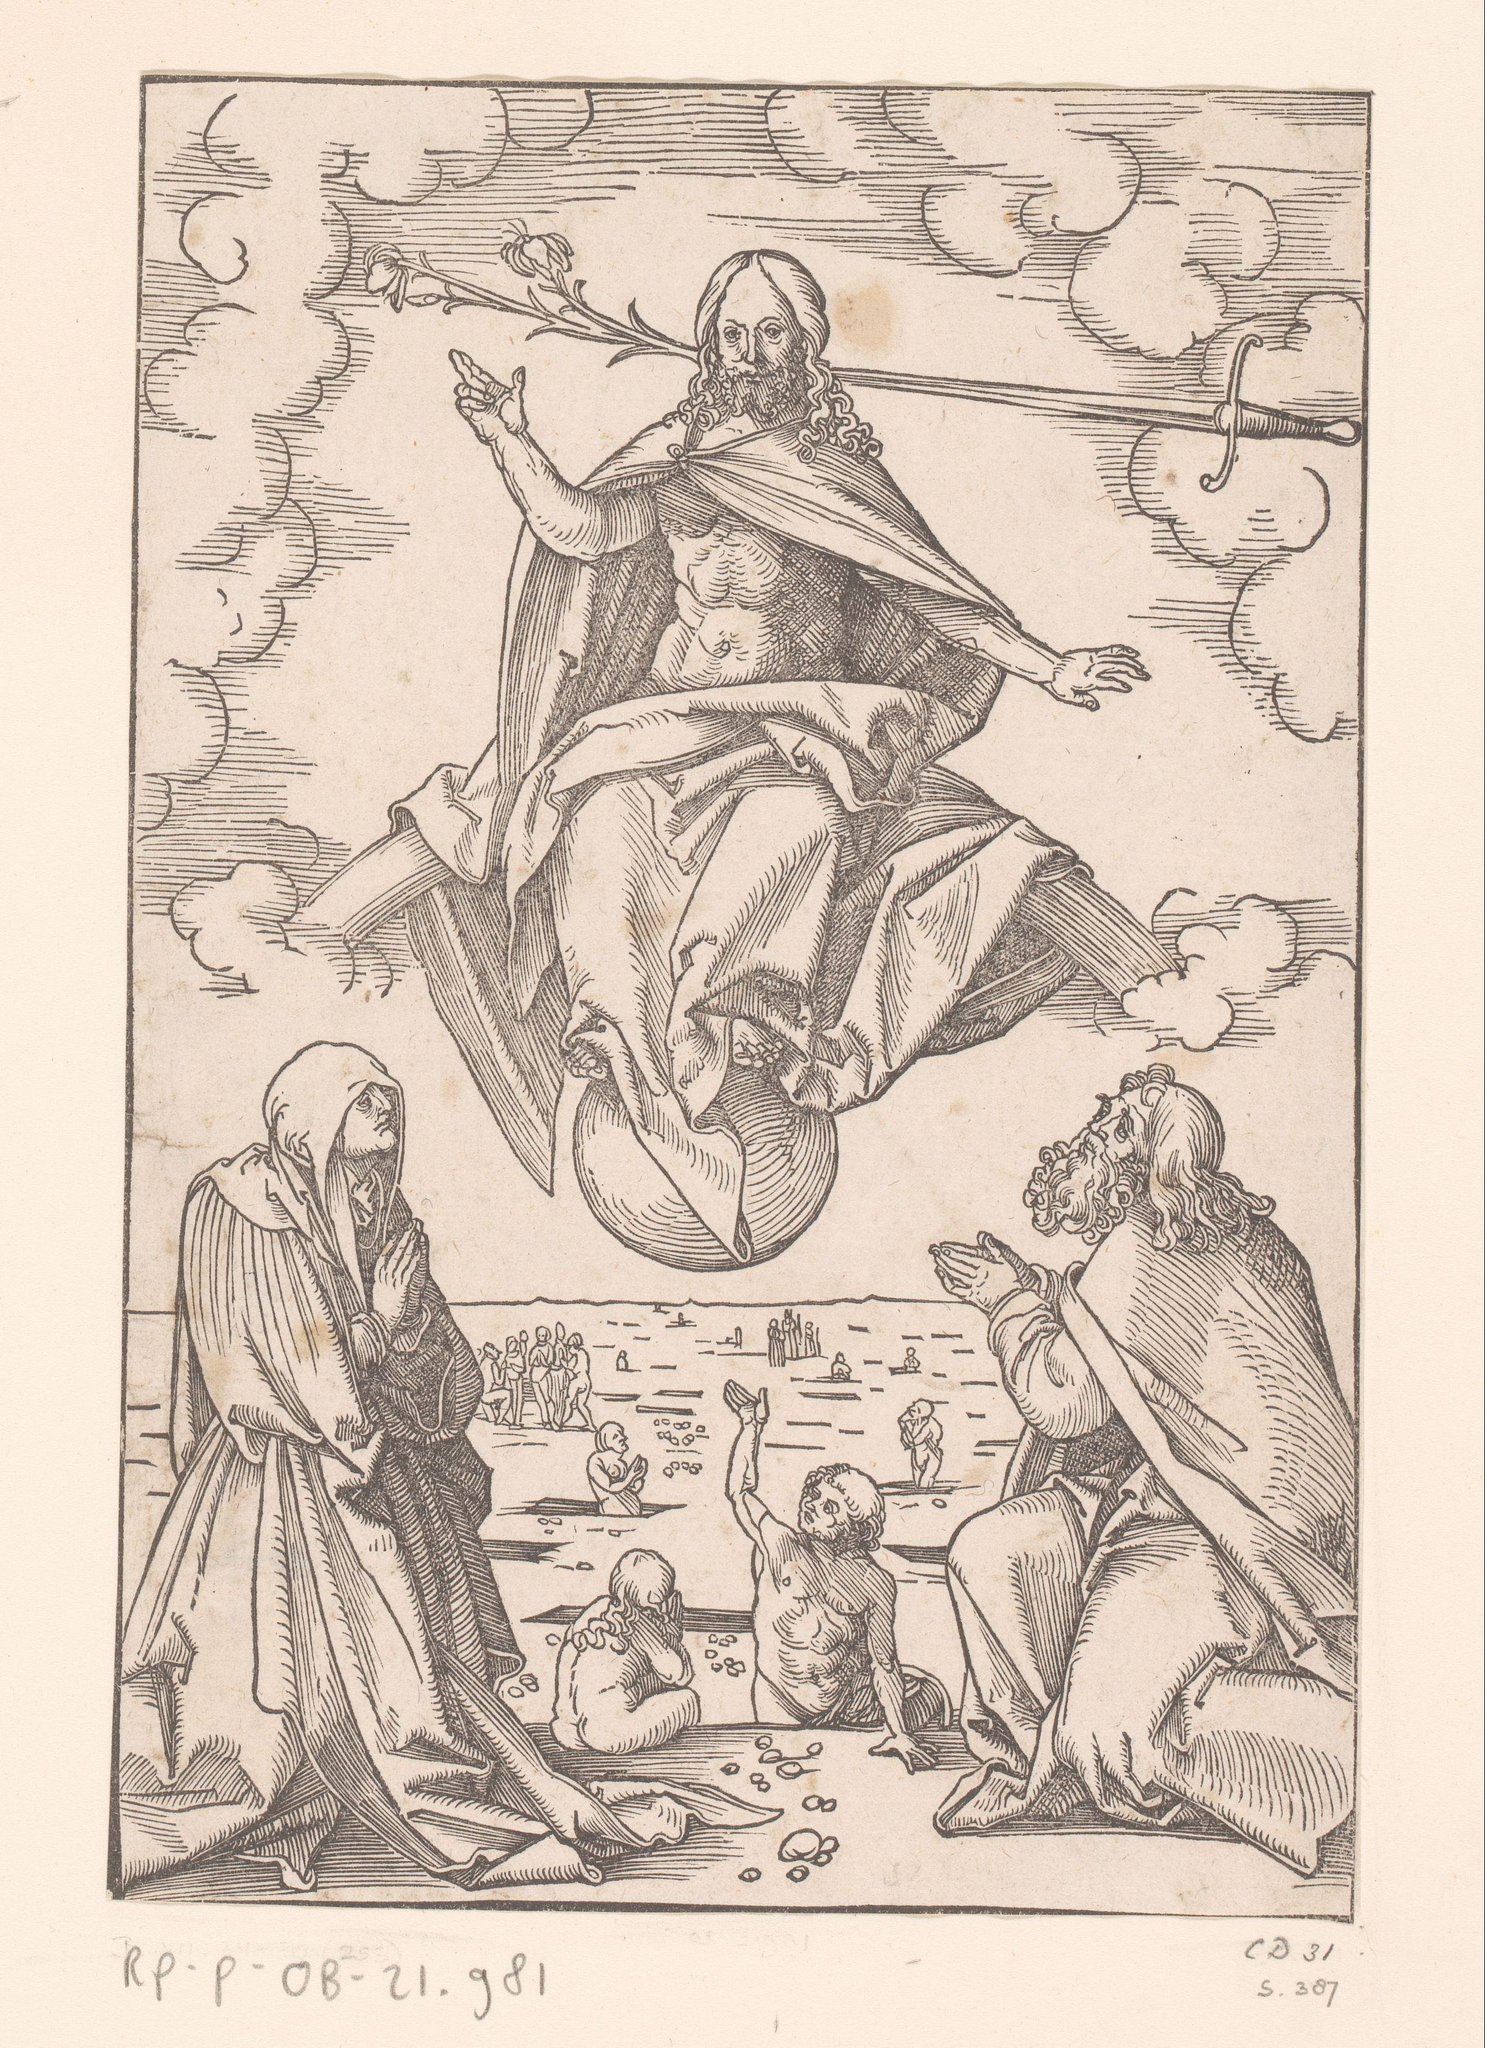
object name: book illustration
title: Laatste Oordeel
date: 1506-1507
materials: paper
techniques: woodcut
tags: resurrection of the dead ~ last judgement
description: Prent voor het eerst gebruikt in: Speculum Passionis. Neurenberg: Ulrich Pinder, 1507.